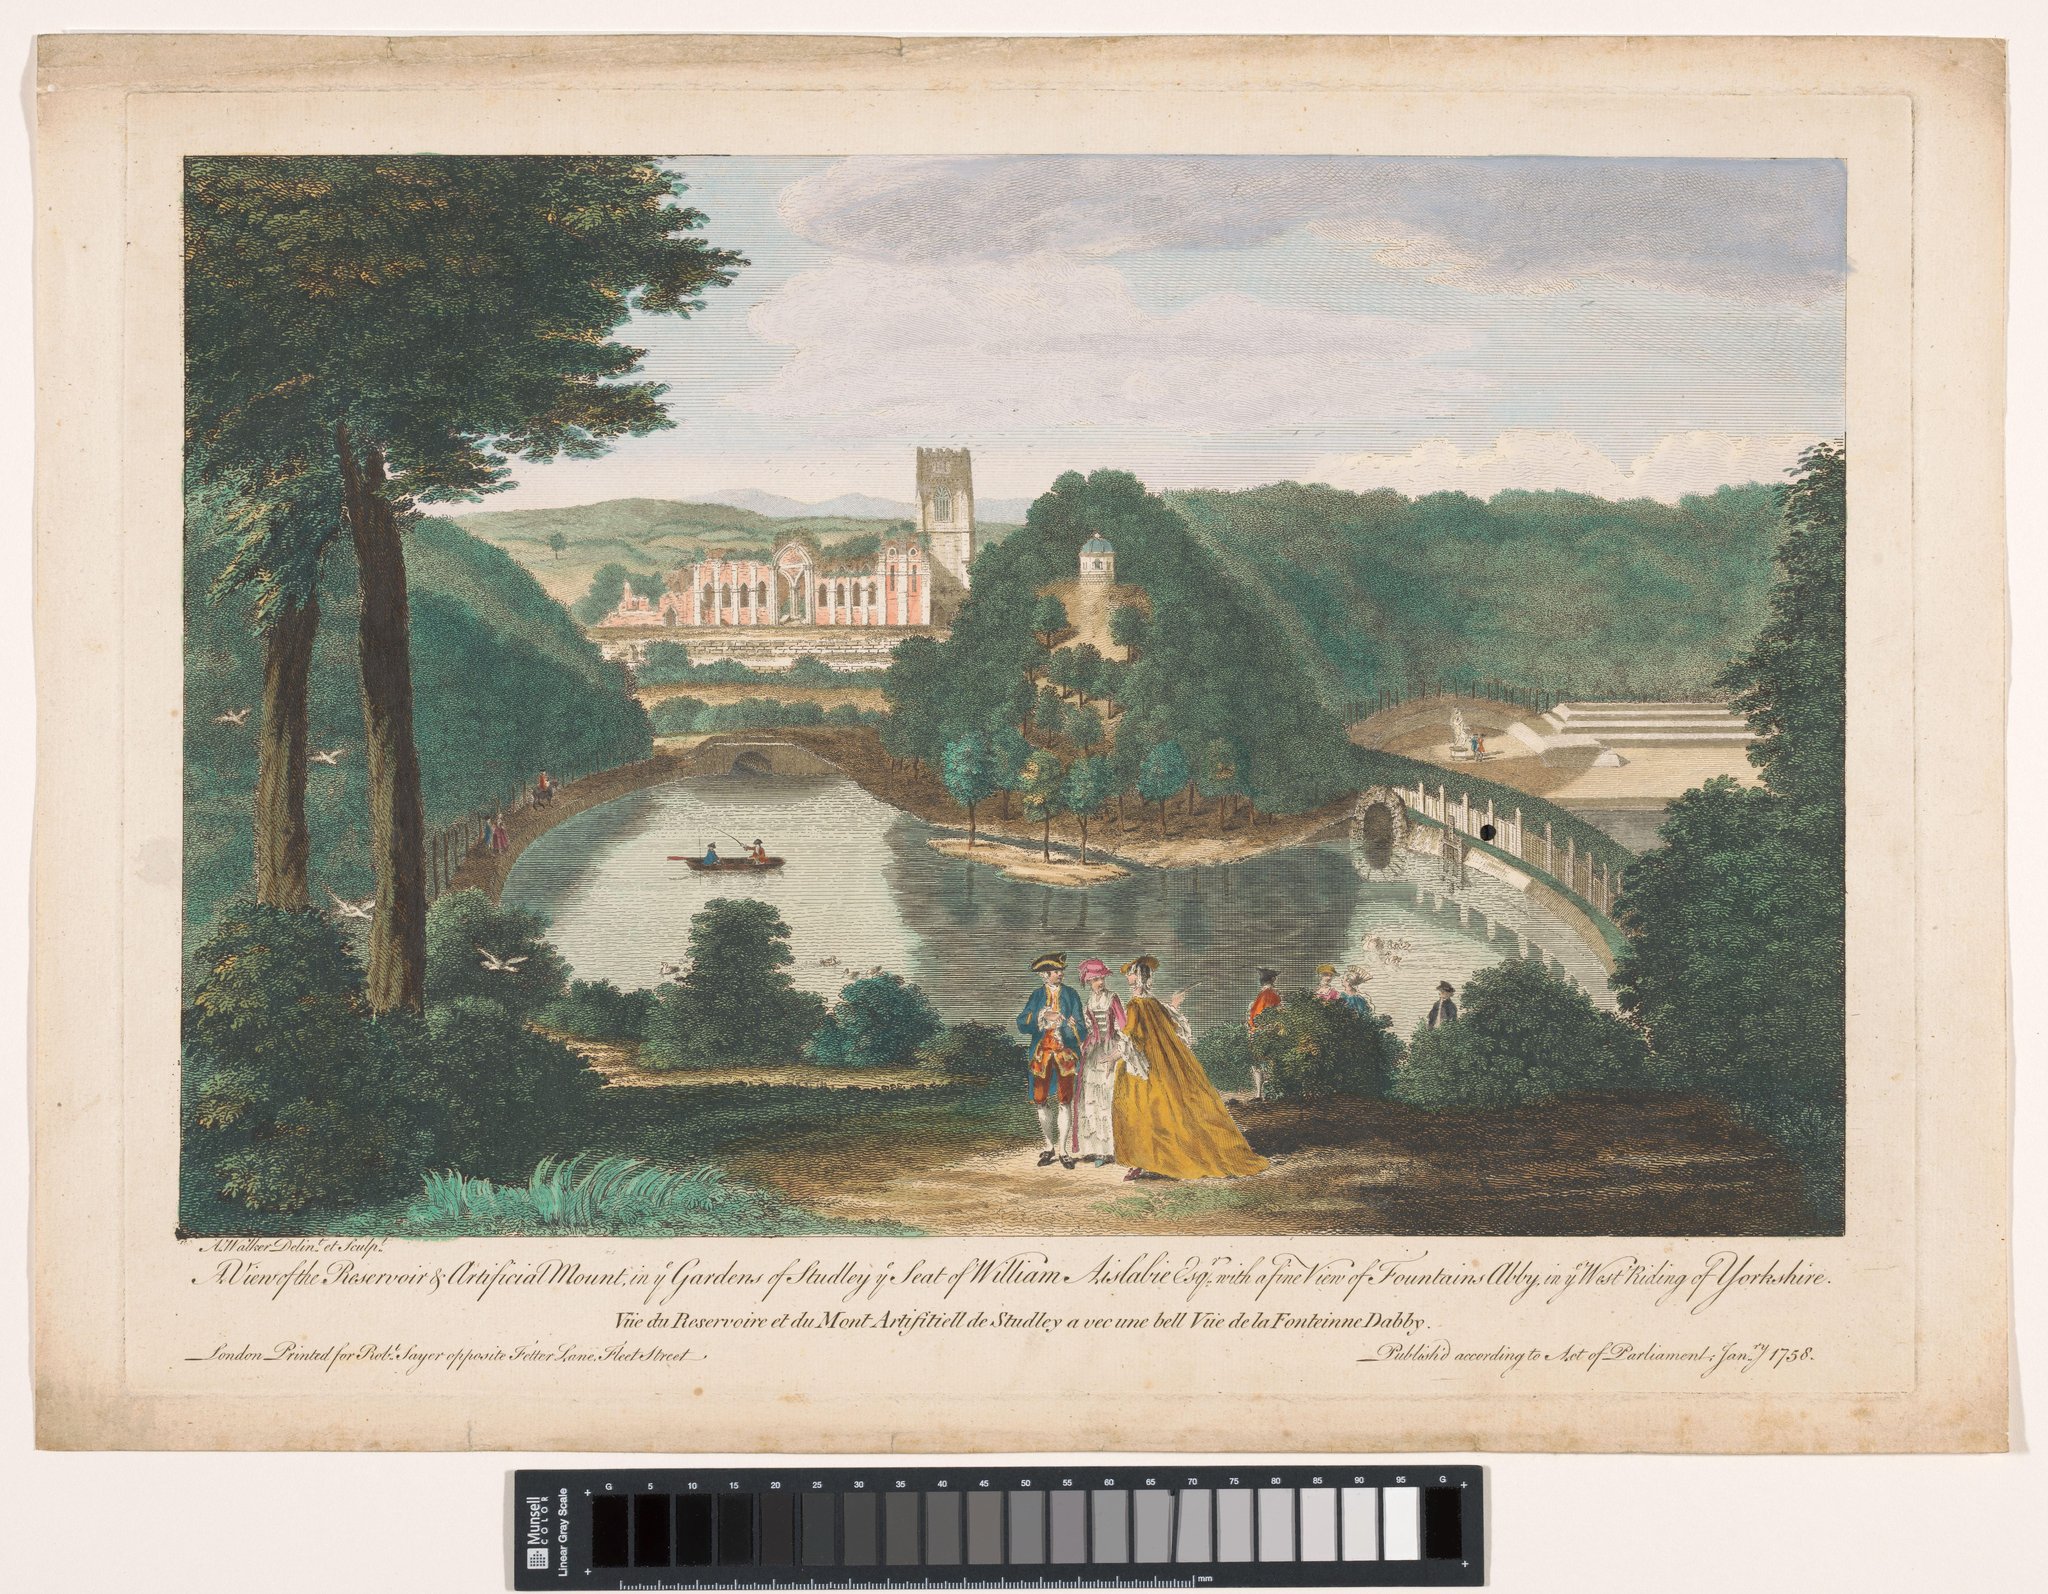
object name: opticaprent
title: Gezicht op Studley Royal Park en Fountains Abbey te Yorkshire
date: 1701-1758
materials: paper, watercolor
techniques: brush, etching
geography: london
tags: garden, abbey, monastery, convent ~ roman catholic church, garden ornaments, water-works in garden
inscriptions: date